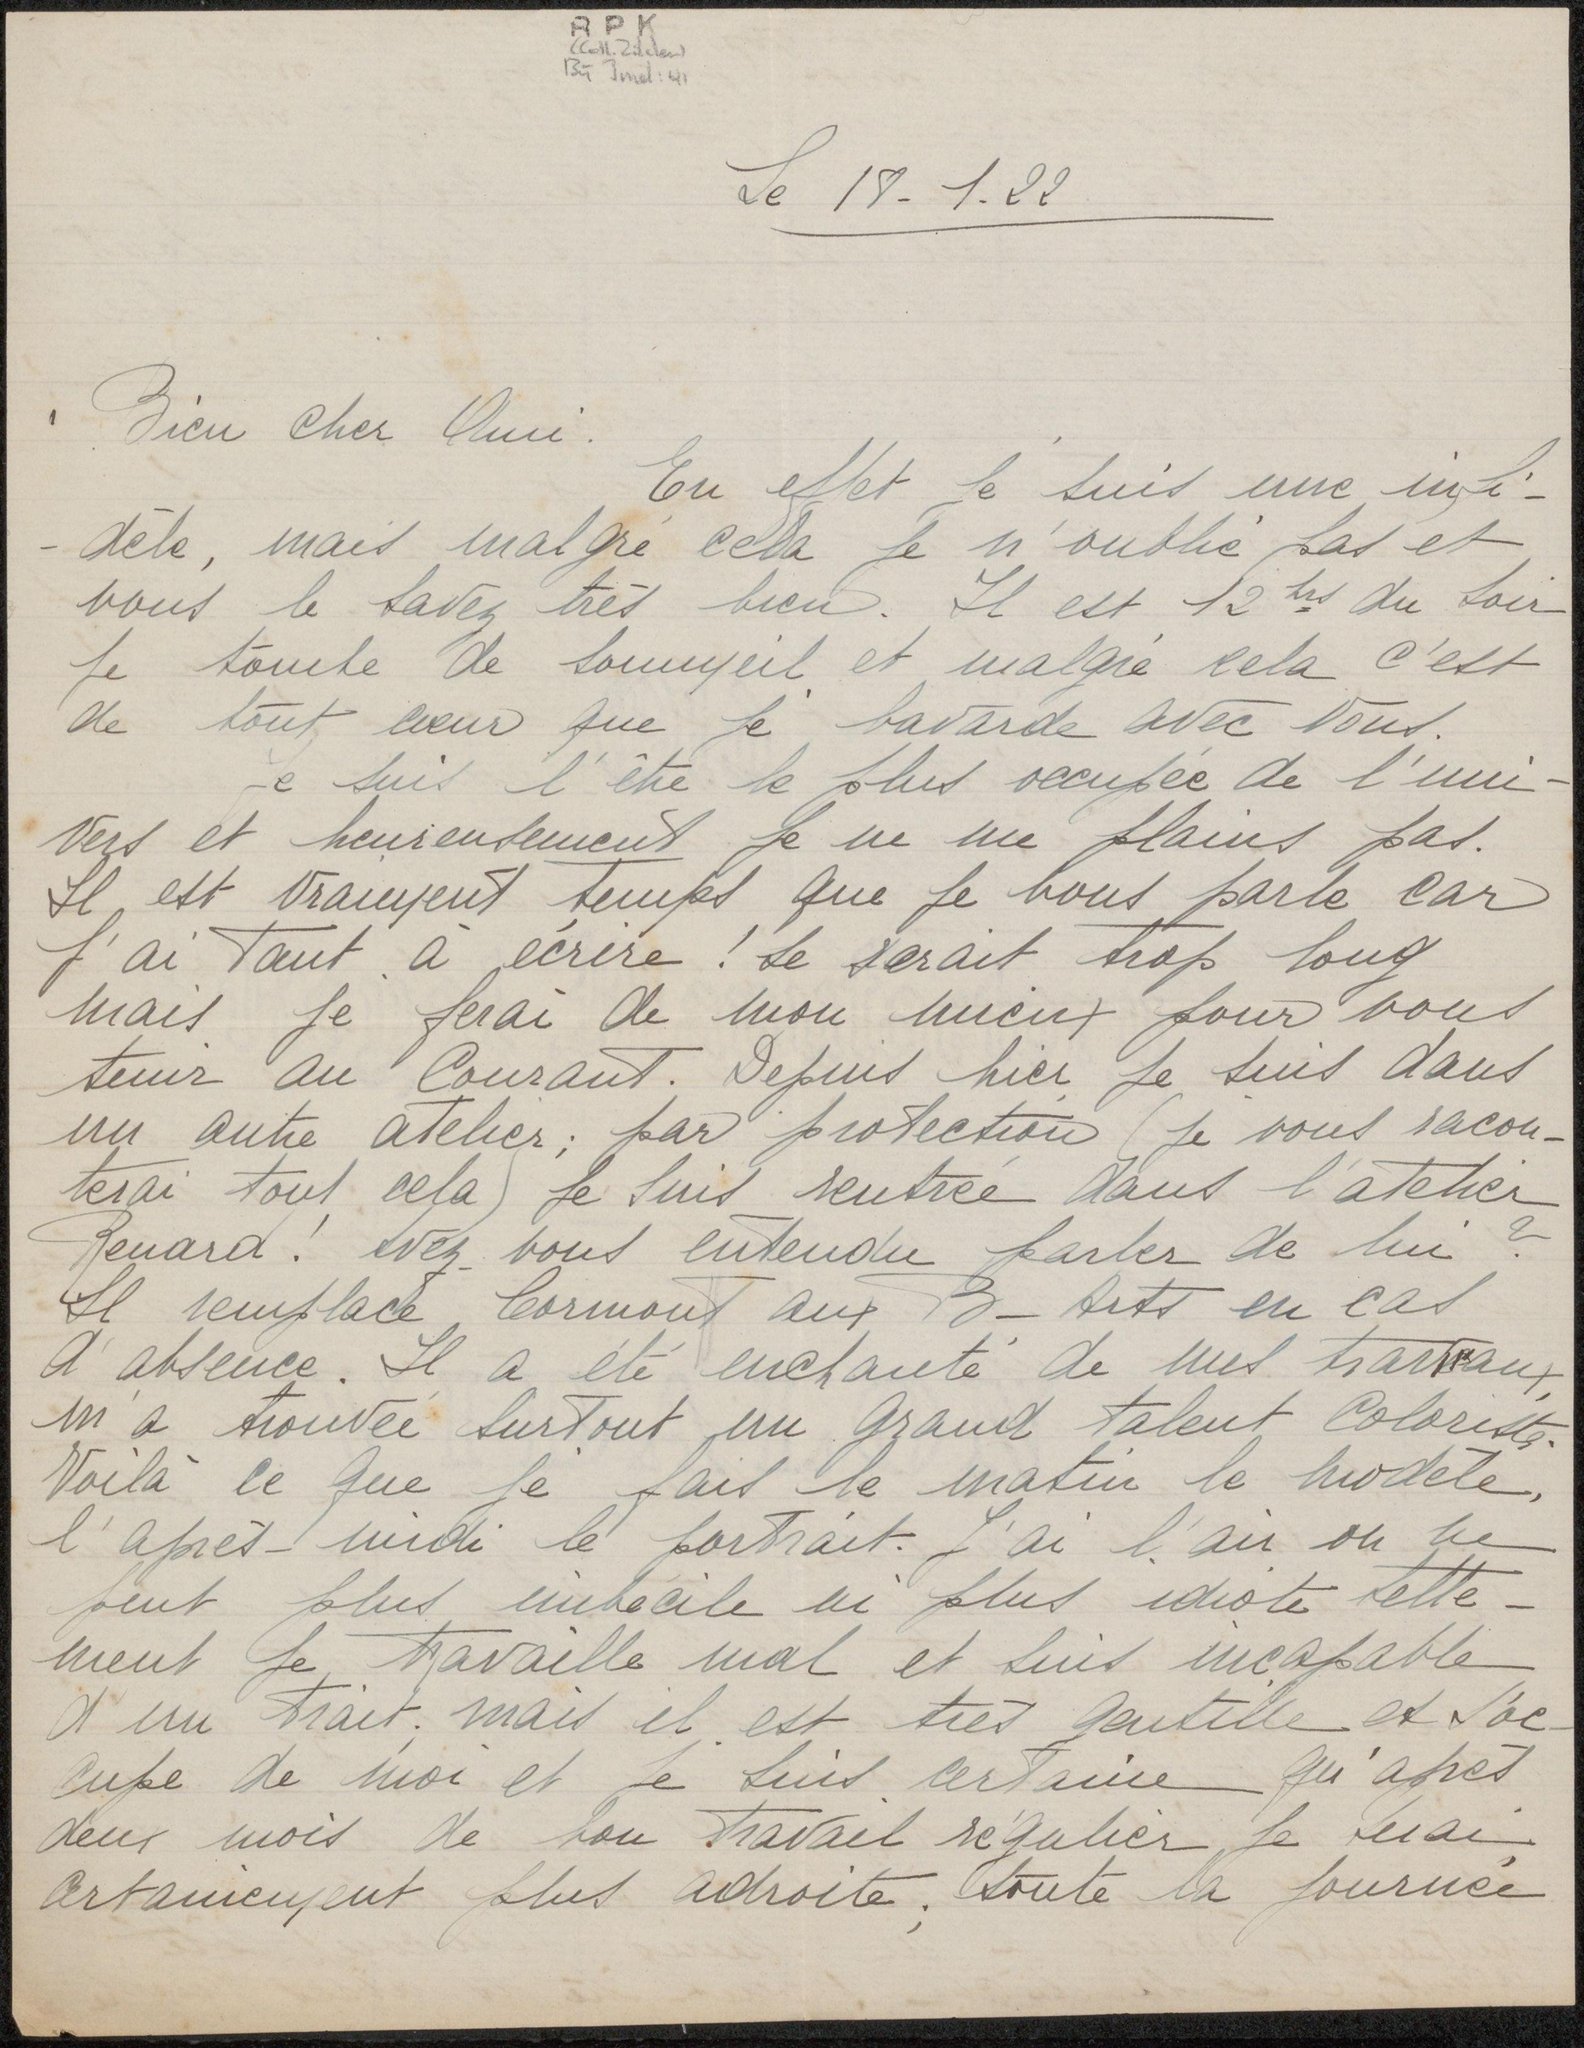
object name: letter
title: Brief aan Philip Zilcken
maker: rose imel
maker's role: draughtsman, painter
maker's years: 1901-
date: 1922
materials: ink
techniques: pen, writing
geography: paris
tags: amsterdam, isaac israels, the hague, painter, philip zilcken, artist's model, sitter, anonymous historical person portrayed, workshop, studio of the artist (in general), london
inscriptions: collector's mark: ‘RPK’